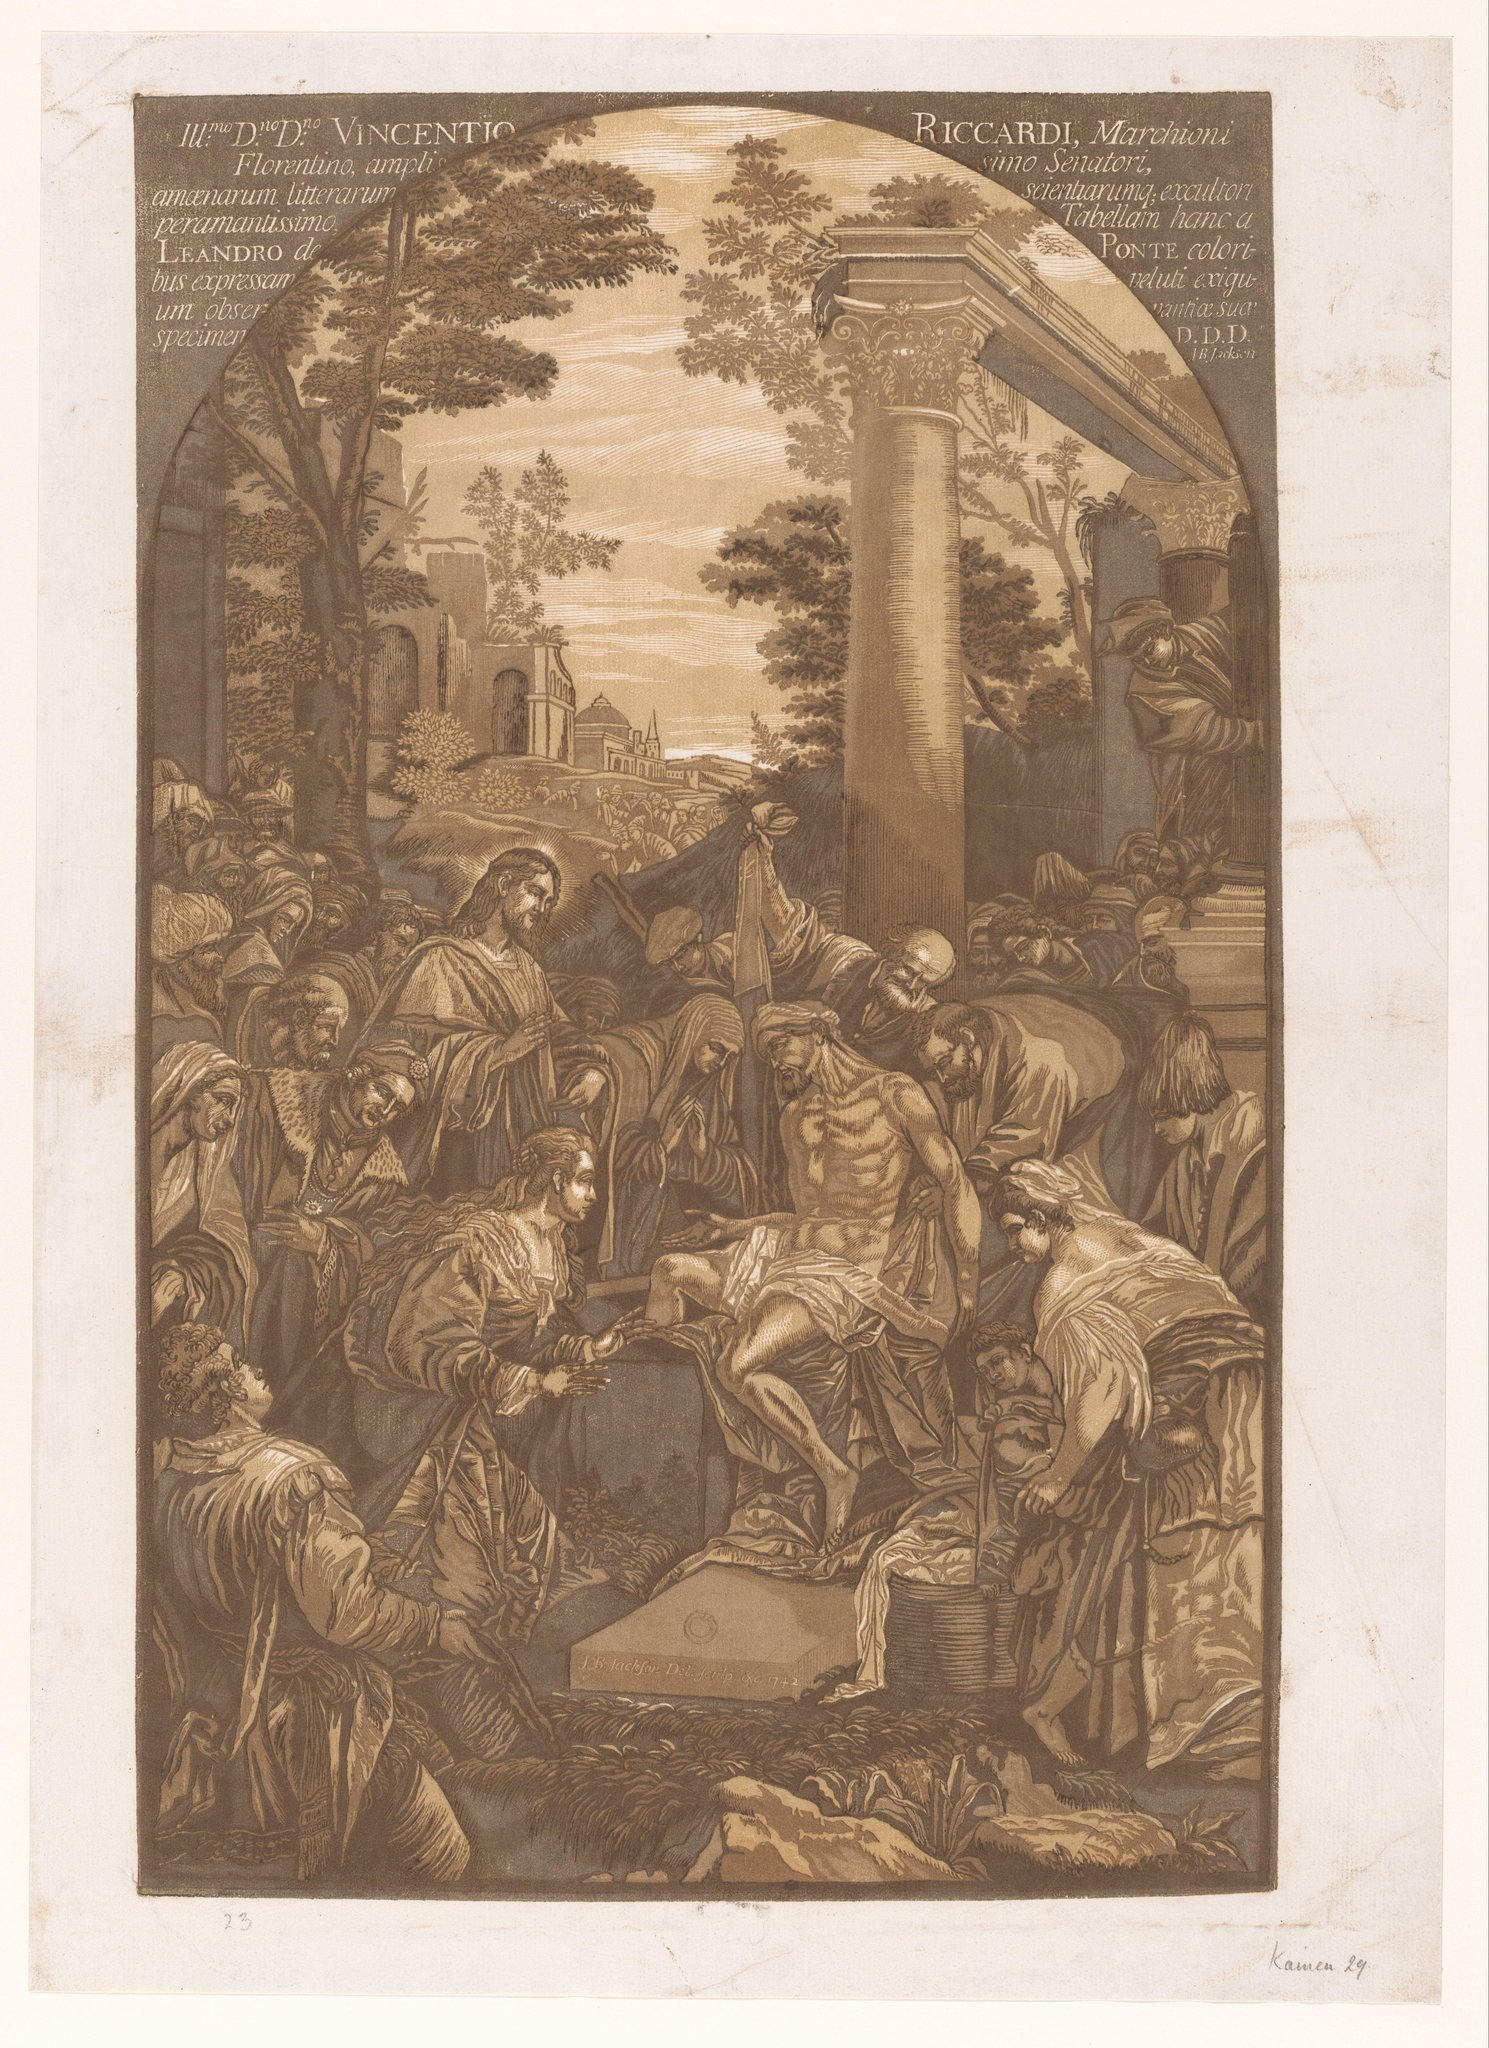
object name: print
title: Opwekking van Lazarus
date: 1745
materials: paper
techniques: woodcut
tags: the raising of lazarus ('lazarus, come out')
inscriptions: collector's mark: Lugt 2228, collector's mark: Lugt 2228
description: Prent maakt deel uit van een ongenummerde serie van 24 prenten.